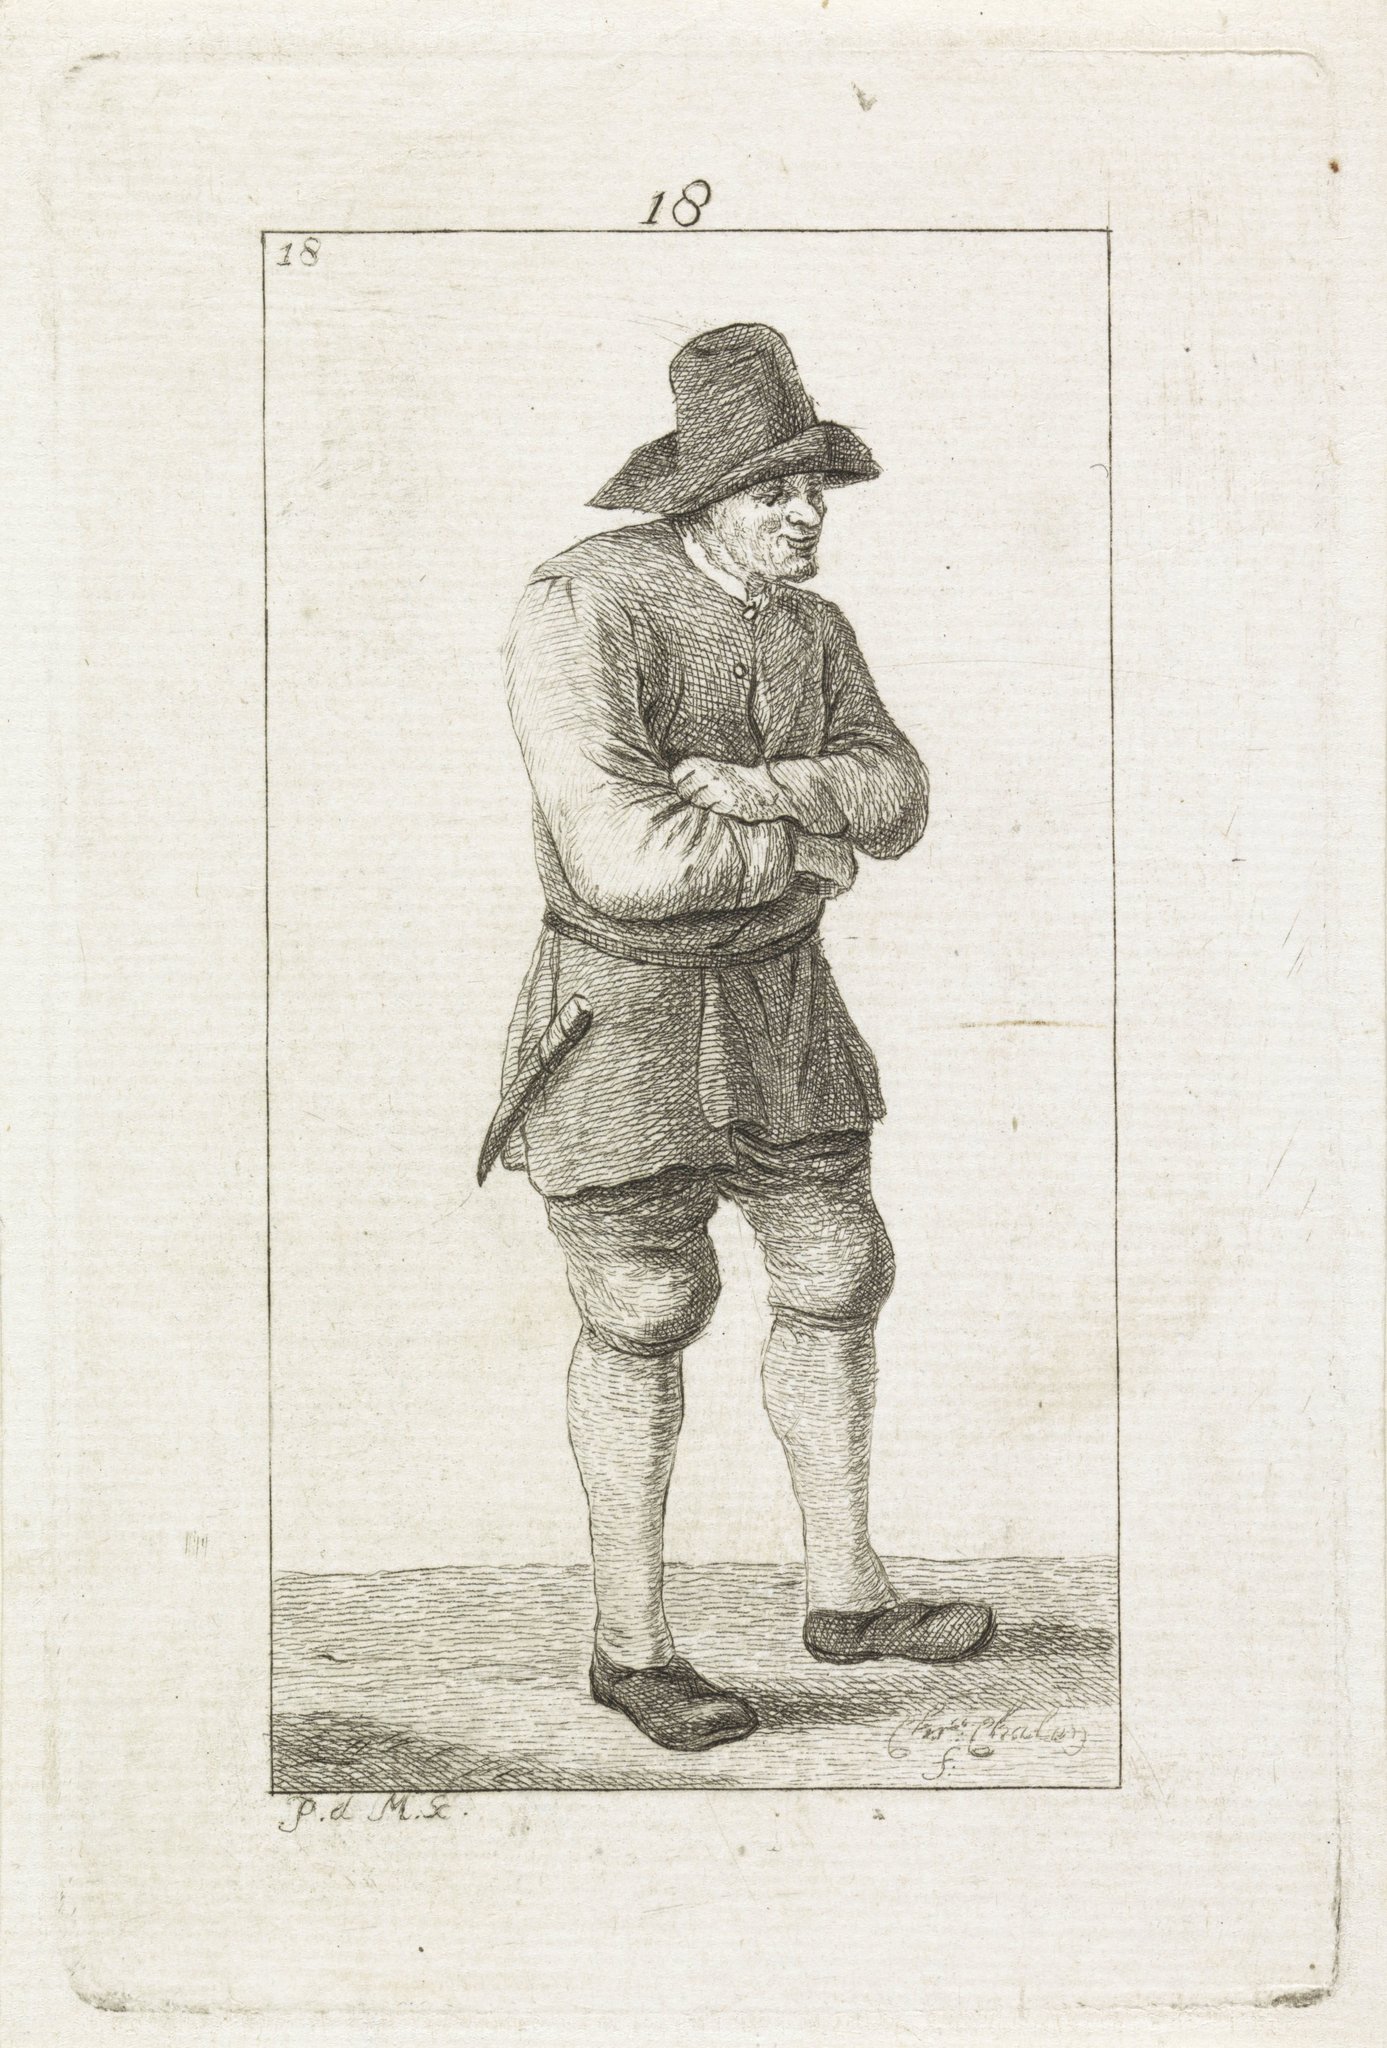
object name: print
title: Man met de armen over elkaar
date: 1779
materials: paper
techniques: engraving, etching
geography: netherlands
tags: folk costume, regional costume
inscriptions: collector's mark: Lugt 2228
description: Staande man met de armen over elkaar. Onderdeel van een reeks illustraties van volksklederdrachten uit 1779.